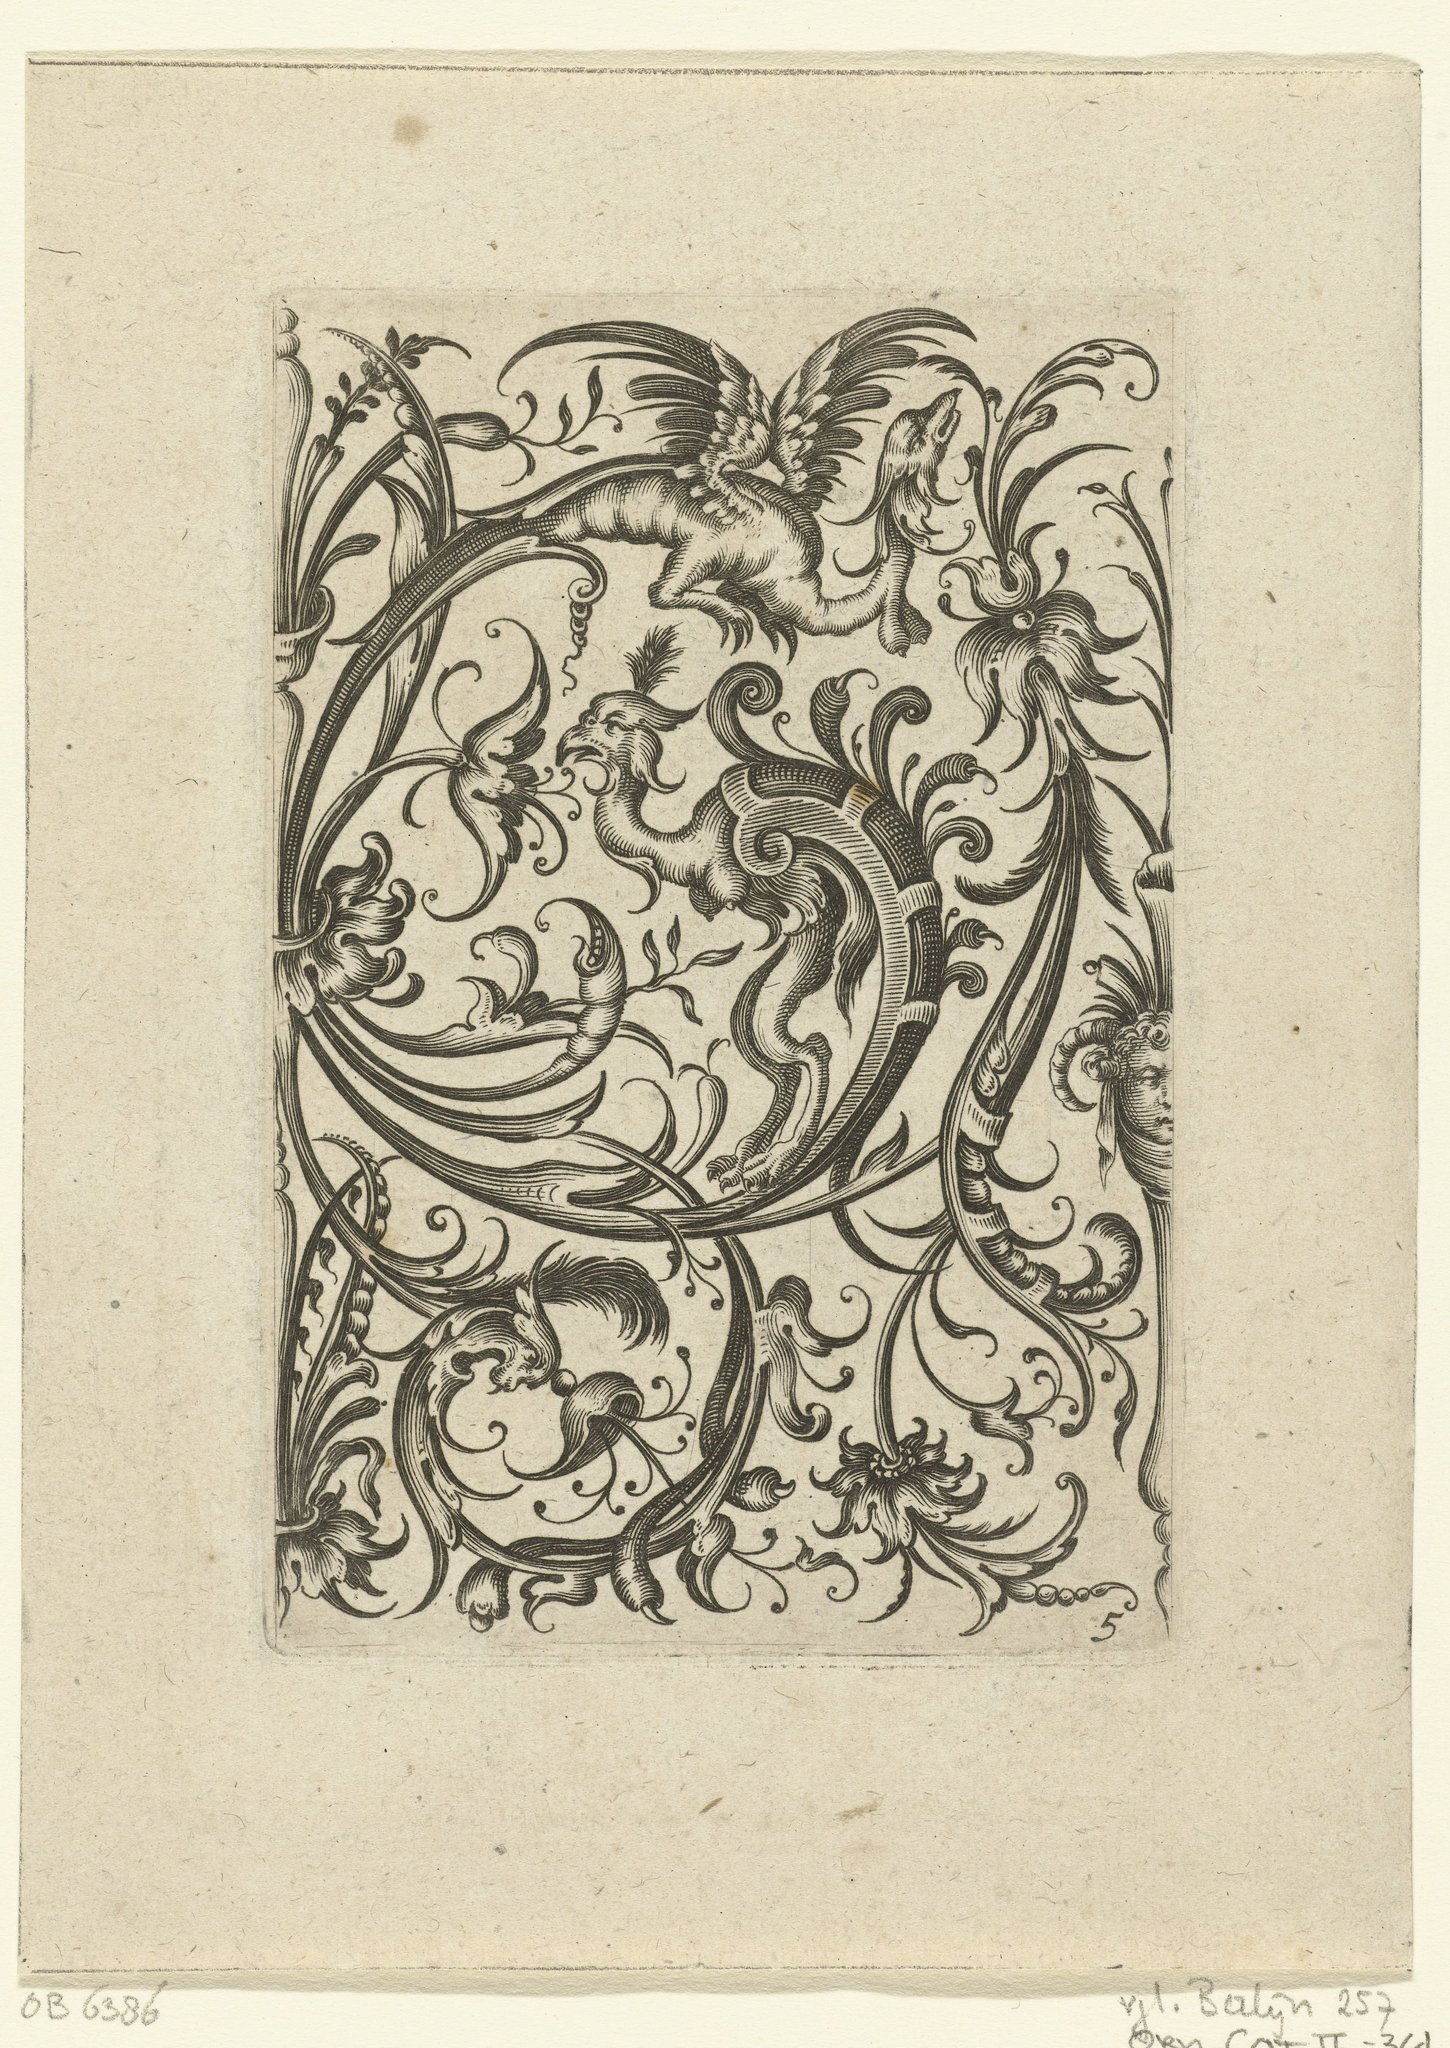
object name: print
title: Seer aerdige Grotissen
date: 1684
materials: paper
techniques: engraving, etching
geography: amsterdam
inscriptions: date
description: Blad uit serie met tegenzijdige kopieën naar de serie De Grotesco van Nicasius Rousseel.